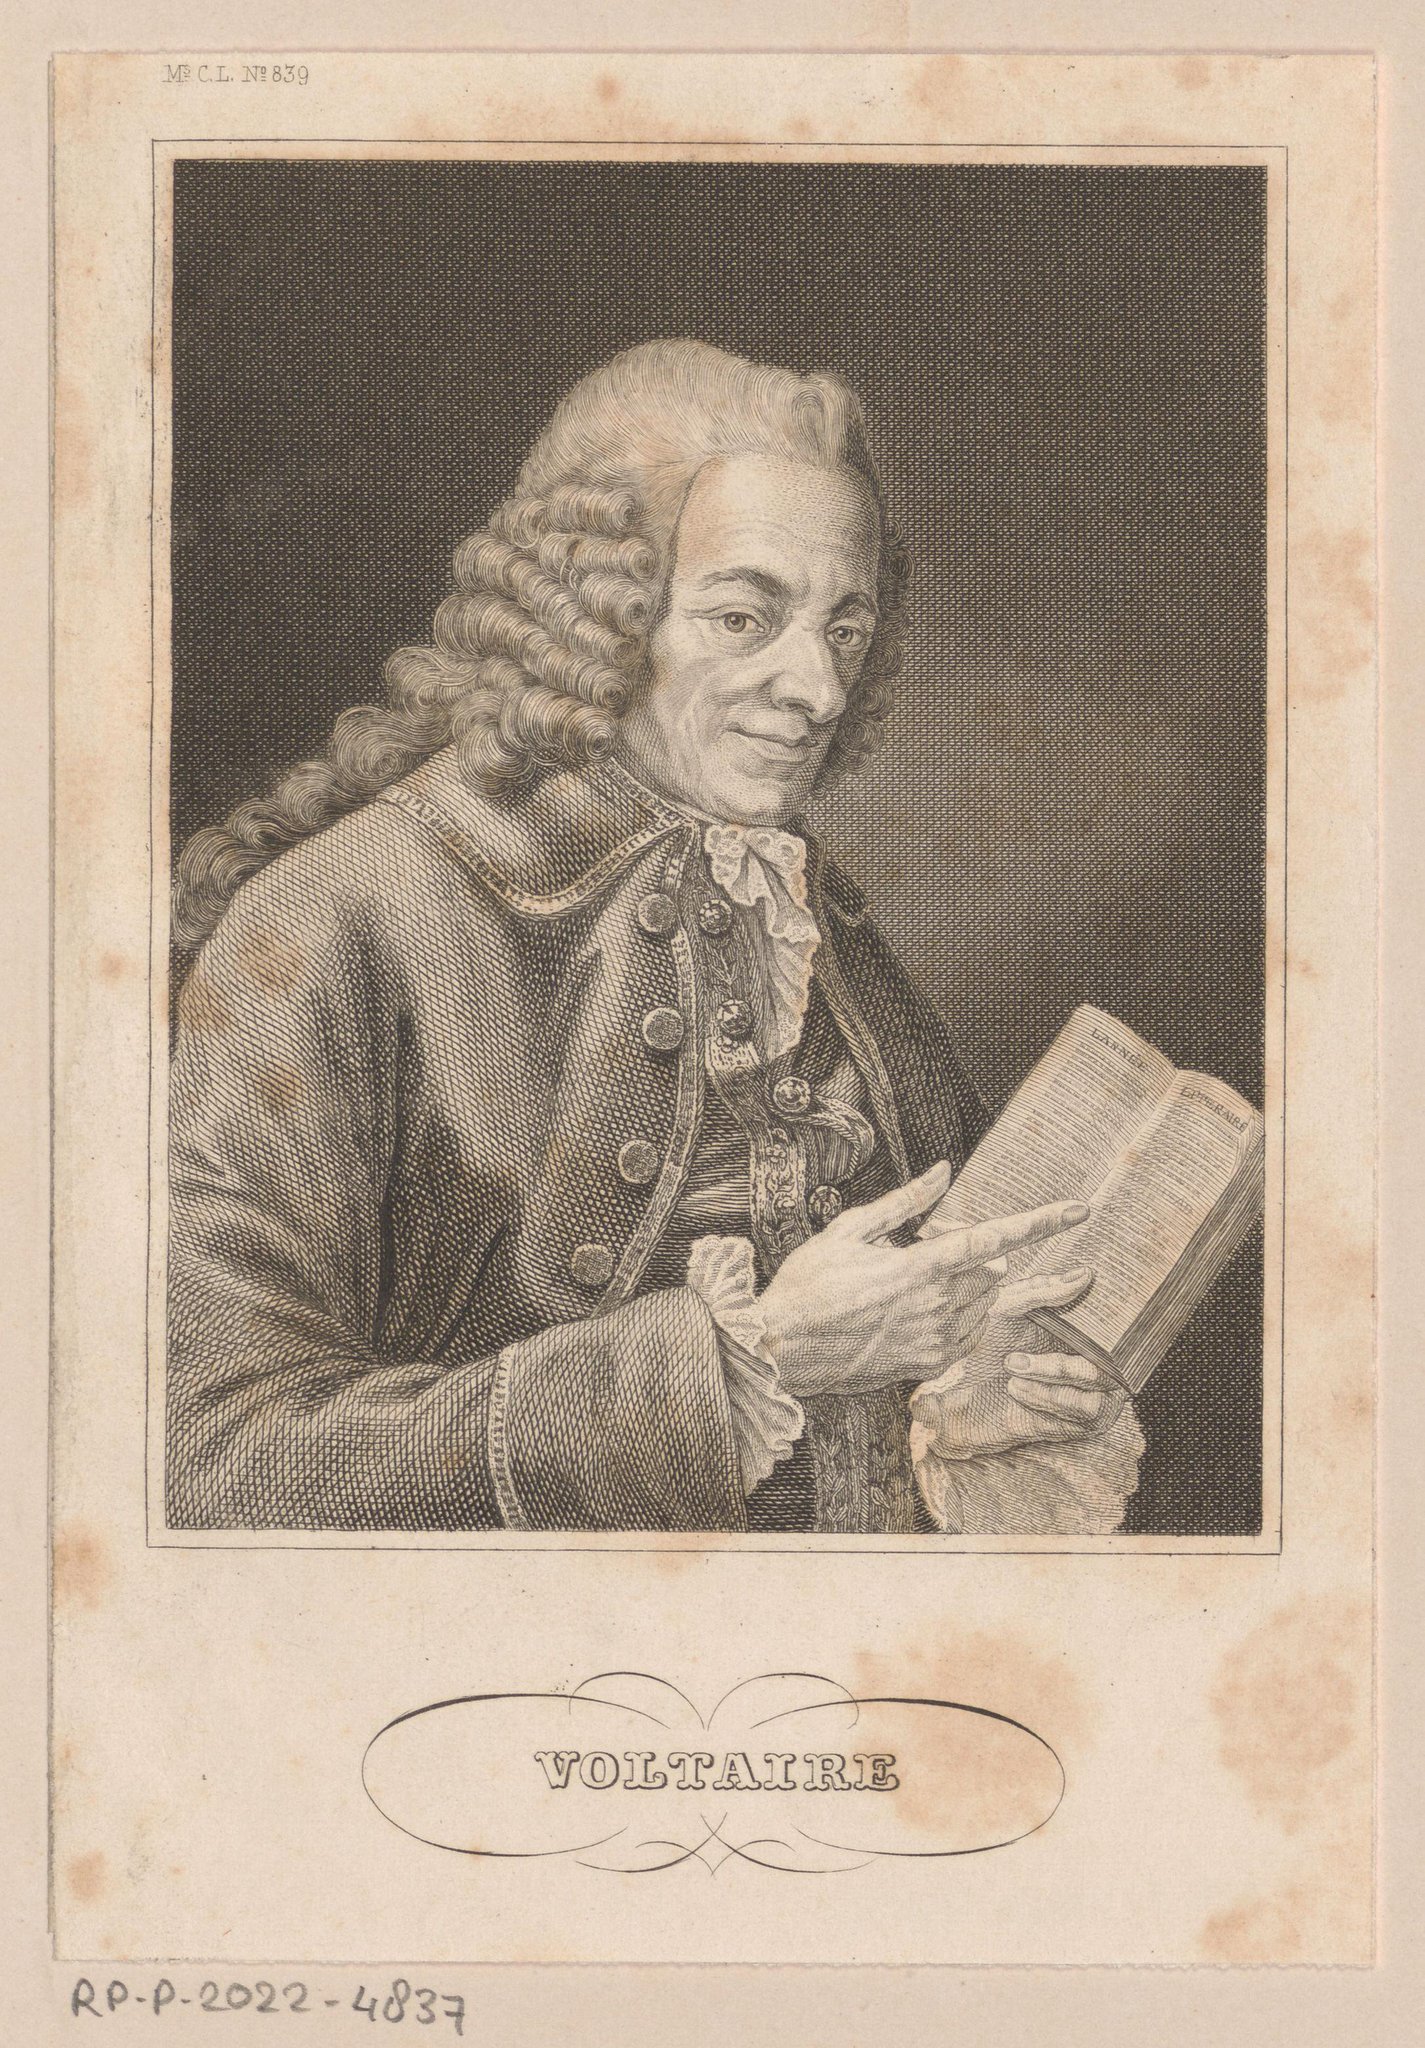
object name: print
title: Portret van Voltaire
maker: Anonymous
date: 1839-1855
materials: paper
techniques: engraving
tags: paris, voltaire, historical persons, portrait of a writer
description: Prent uit: Meyer, Joseph. Das große Conversations-Lexikon für die gebildeten Stände. 52 dln. Hildburghausen: Bibliographisches Institut, [1839-1855].